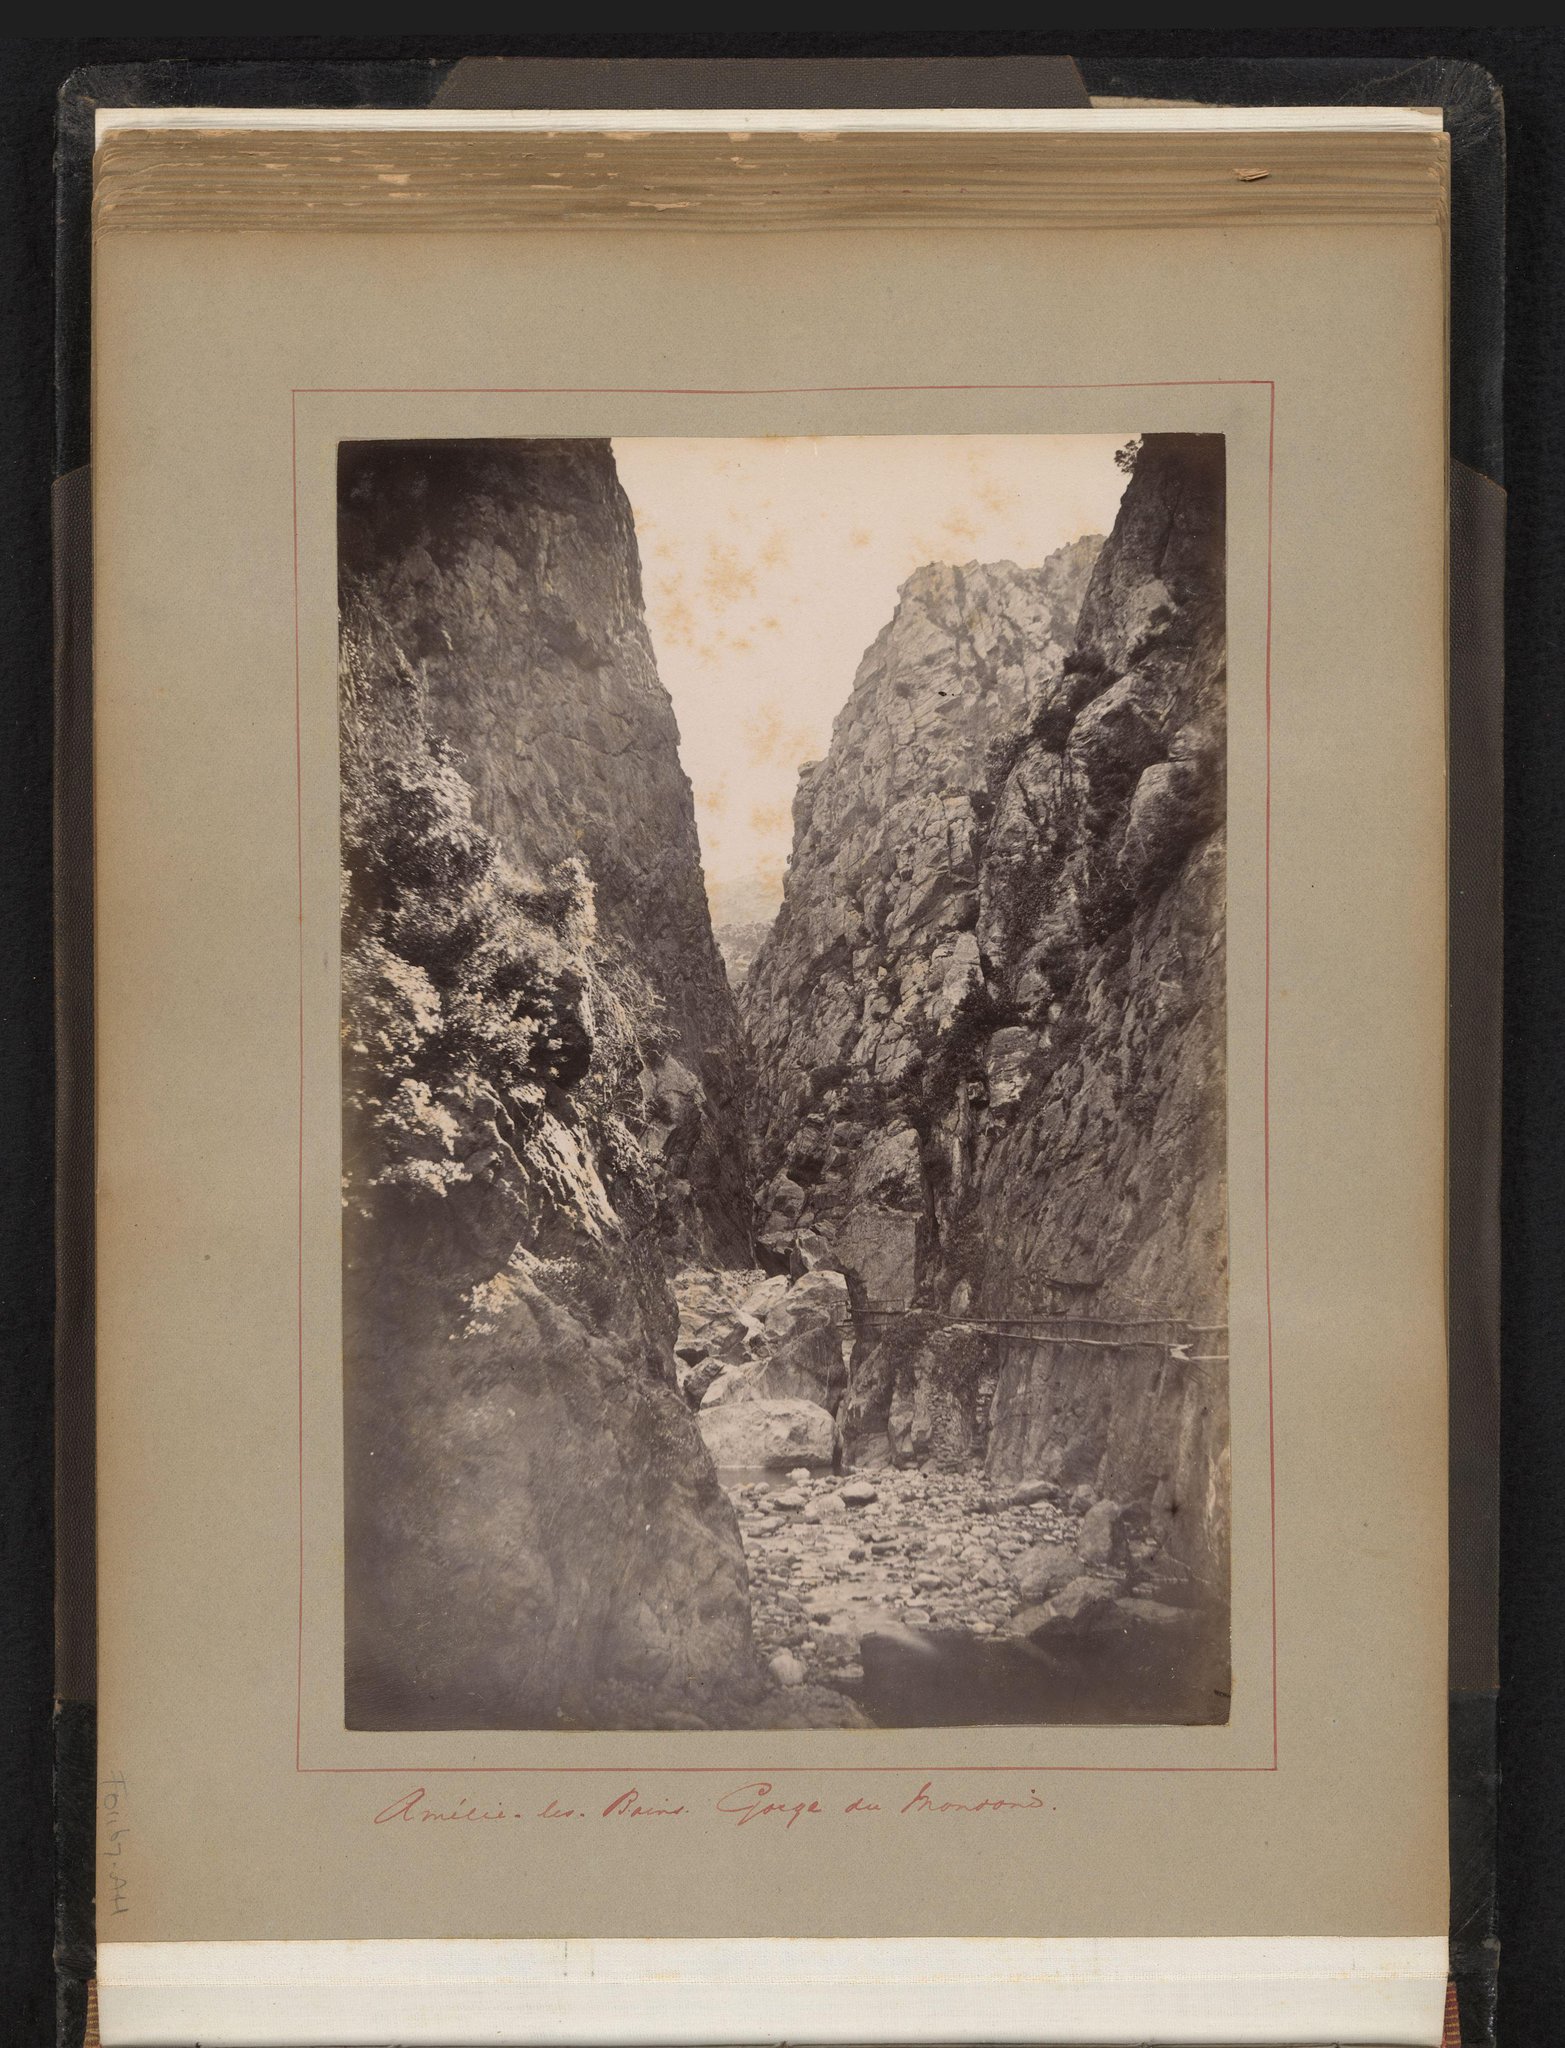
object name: album leaf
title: Kloof van Mondoni te Amélie-les-Bains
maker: Anonymous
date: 1880-1910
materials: photographic support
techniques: albumen print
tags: ravine, chasm, abyss, canyon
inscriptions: annotation: ‘Amélie-les-Bains Gorge du Mondoni’